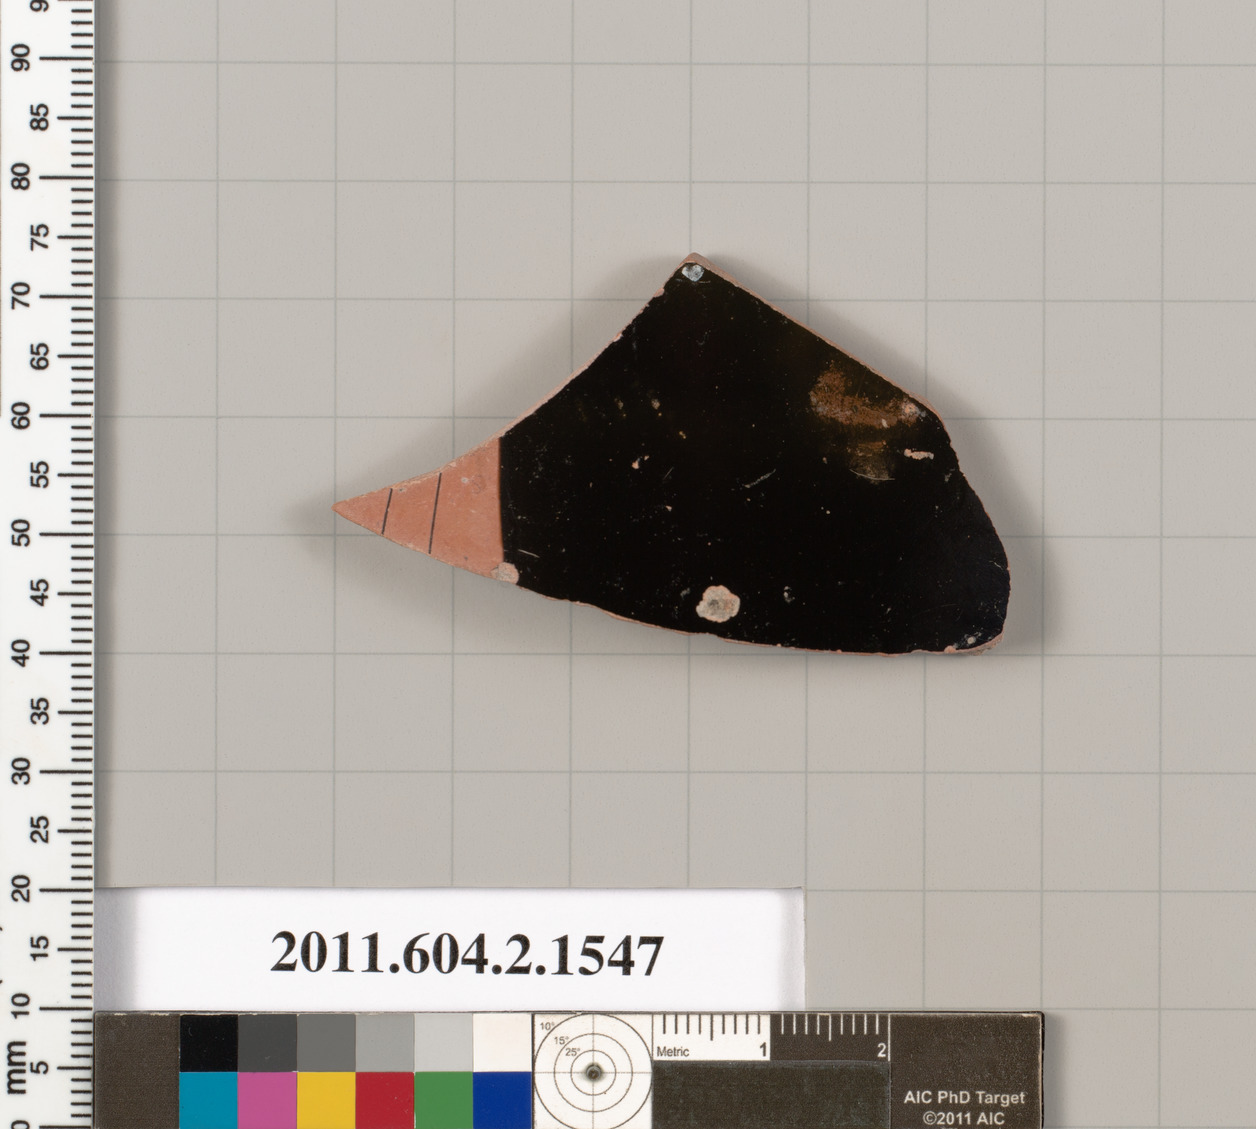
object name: skyphos fragment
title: Terracotta fragment of a skyphos (deep drinking cup)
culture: greek, attic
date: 475-451 BCE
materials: terracotta